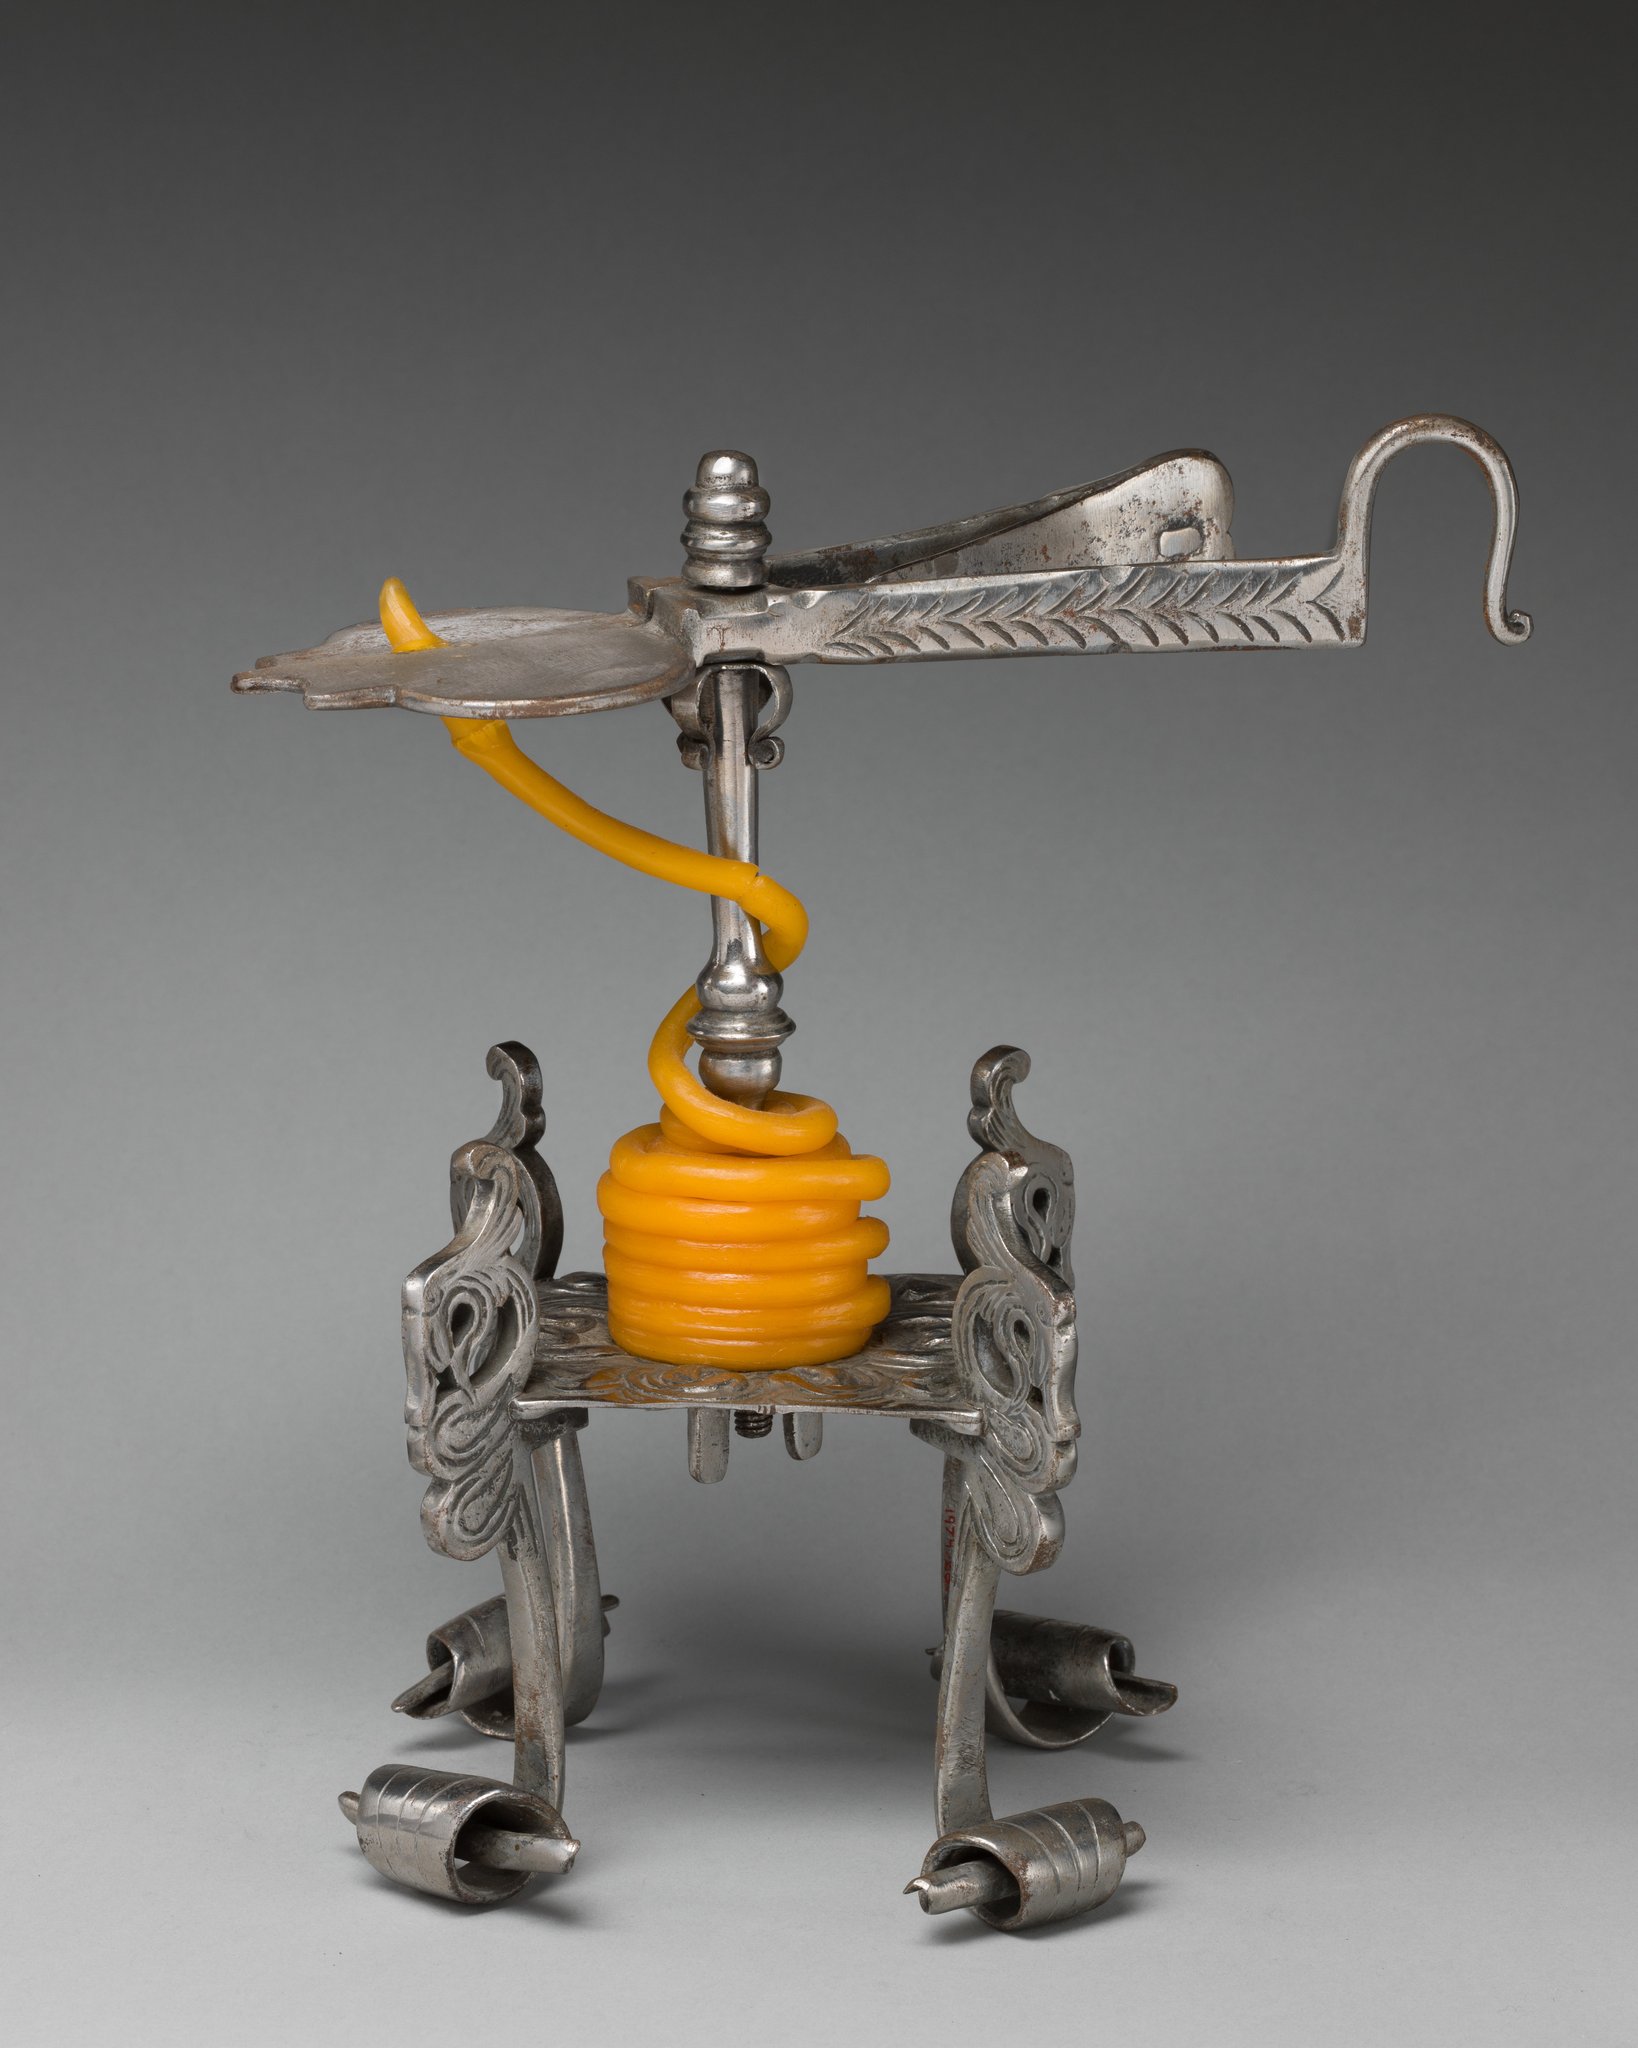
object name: wax jack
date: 1675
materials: steel